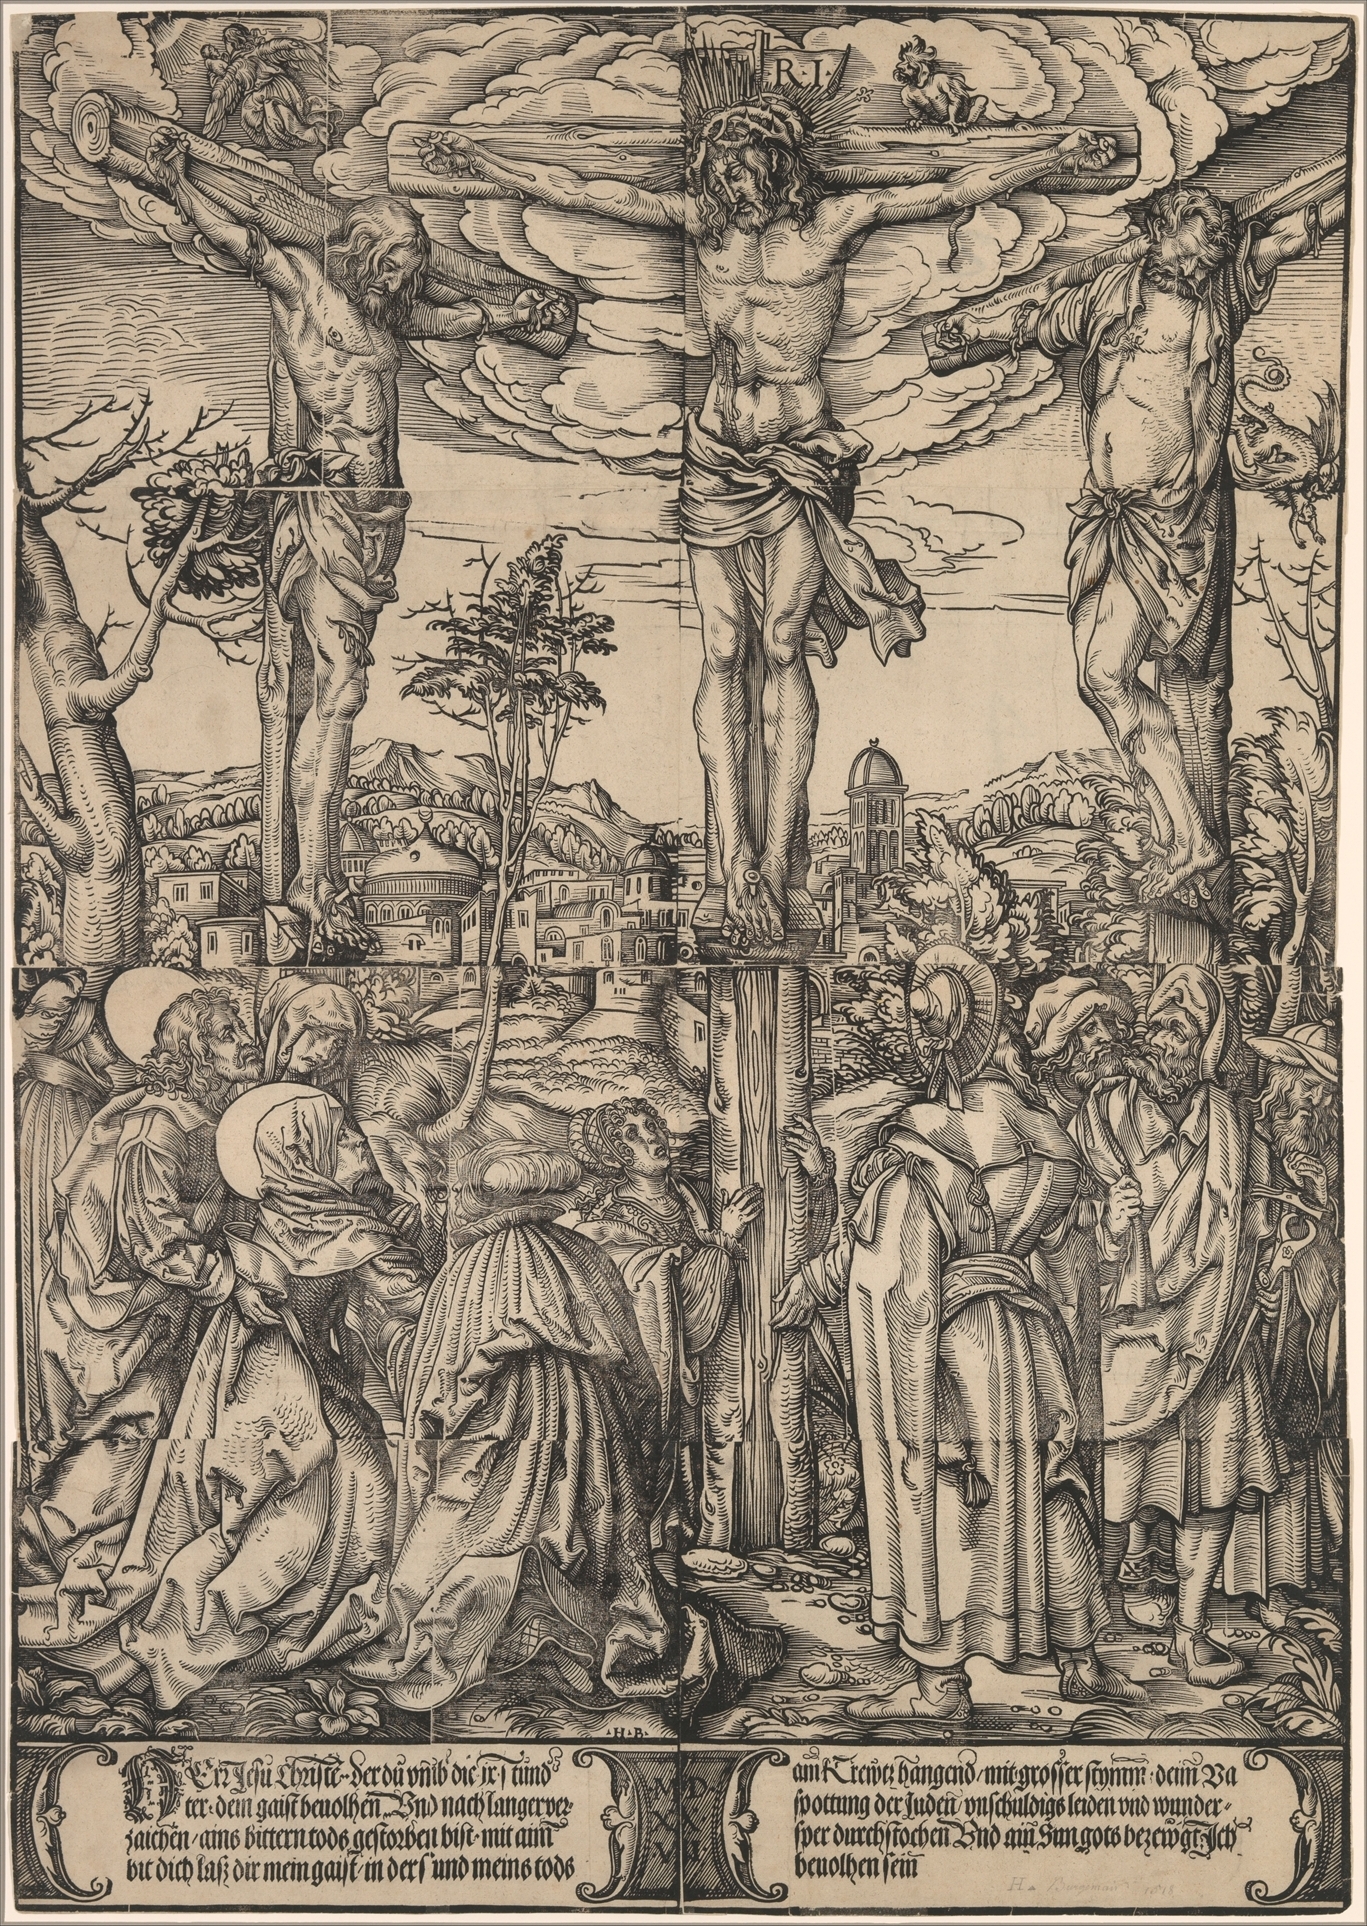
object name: print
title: The Crucifixion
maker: hans burgkmair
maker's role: artist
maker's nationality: german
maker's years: 1473-1531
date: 1527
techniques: printing, woodcut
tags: human figures,cross,crucifixion